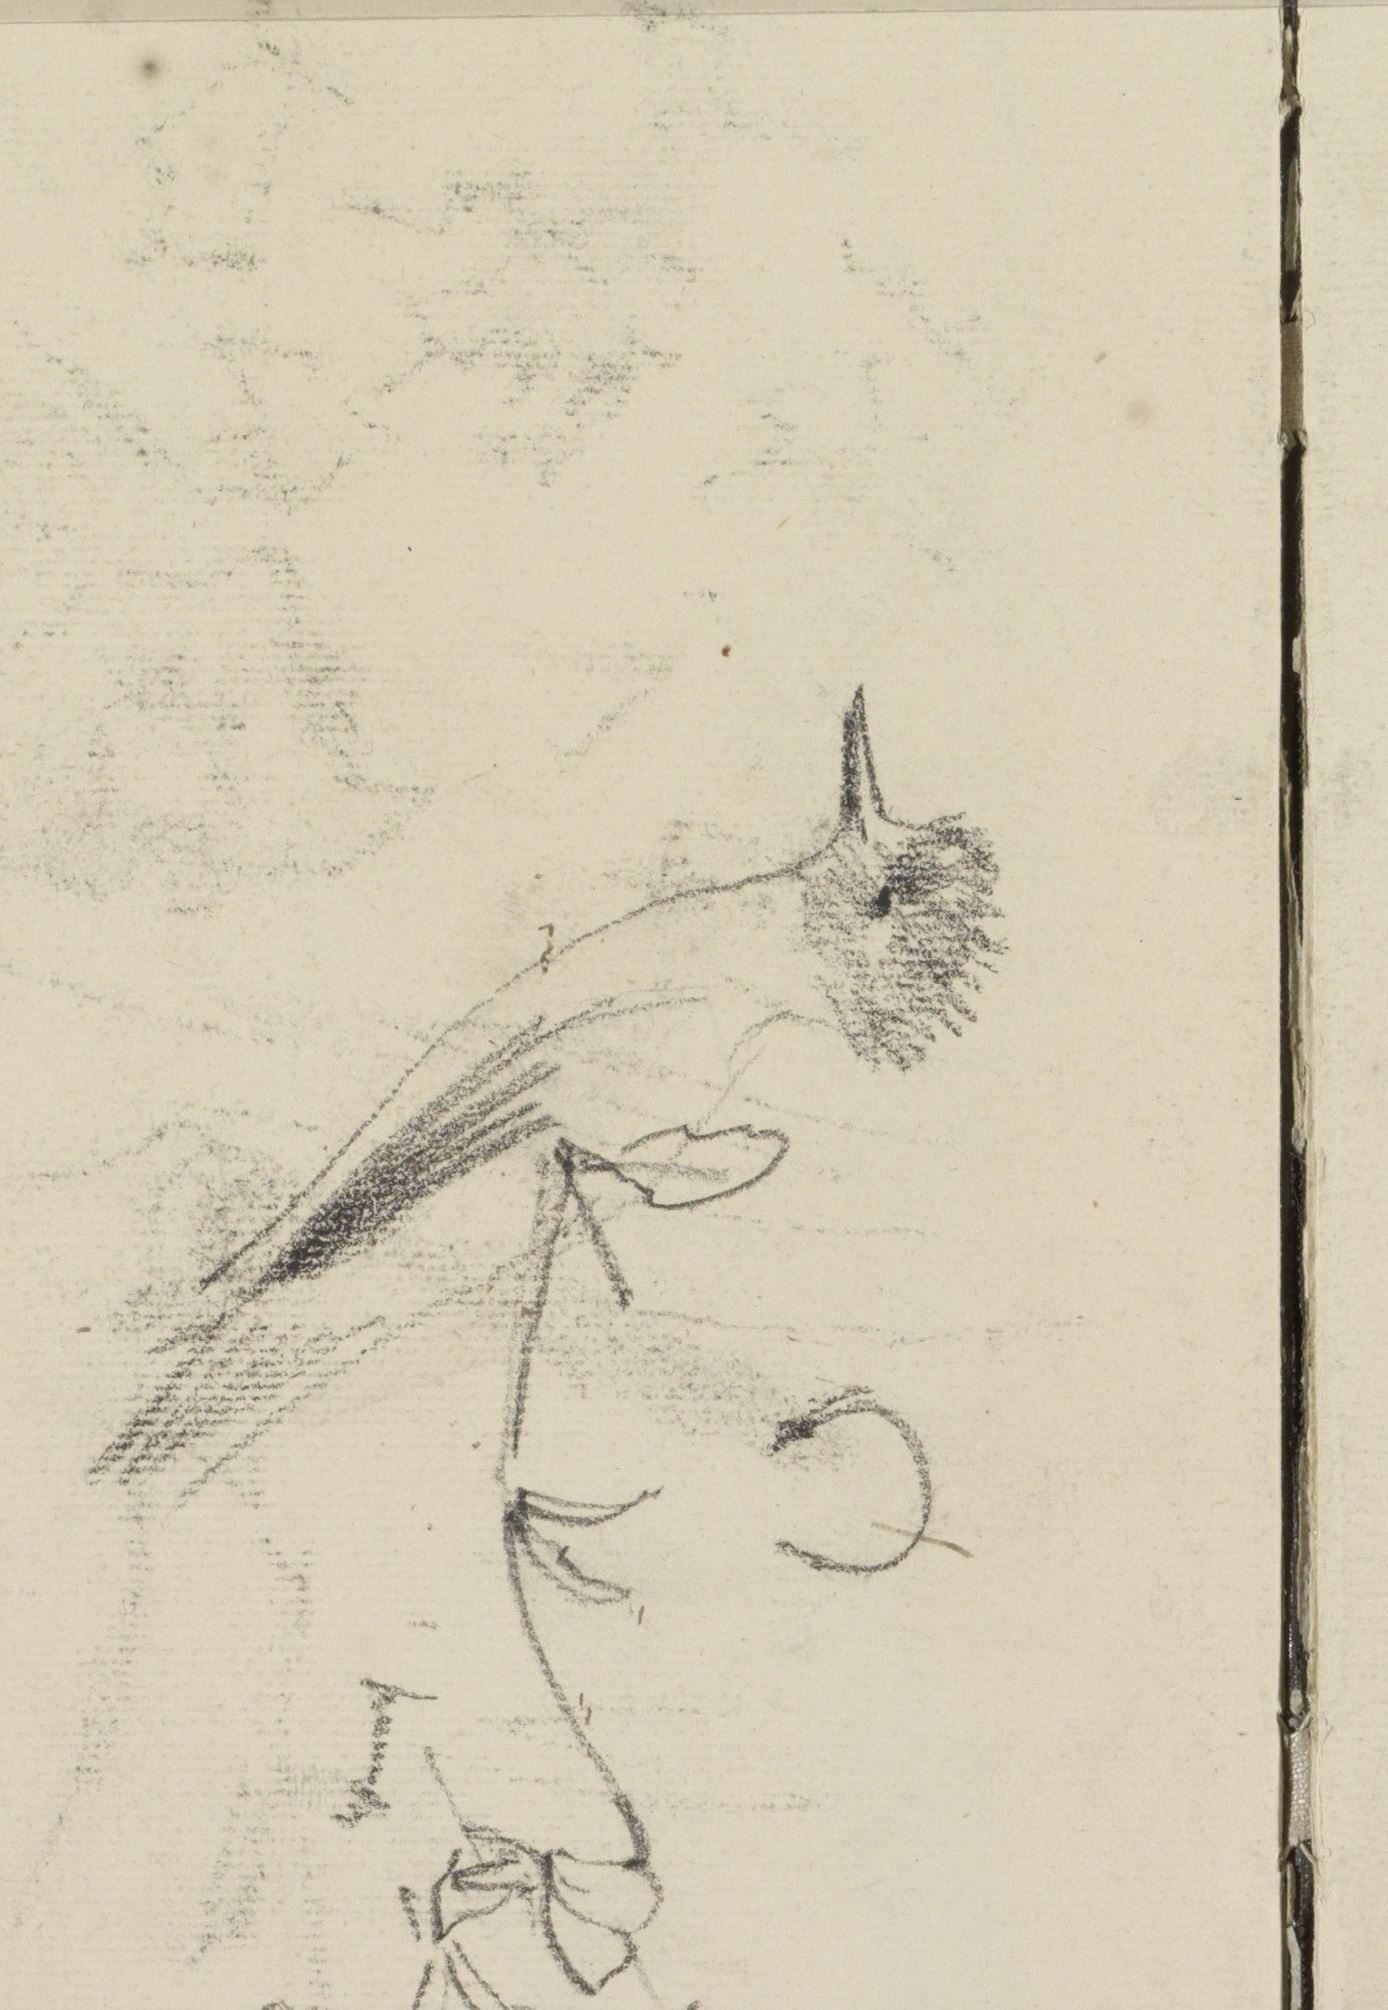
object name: sketchbook leaf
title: Vogel, mogelijk op een tak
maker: george hendrik breitner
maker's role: draughtsman, painter, print maker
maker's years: 1857-1923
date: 1886-1923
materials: chalk, paper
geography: amsterdam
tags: trees (+ branch, stick), birds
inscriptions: kleurnotitie, handgeschreven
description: Pagina 19 uit een schetsboek met 17 bladen.